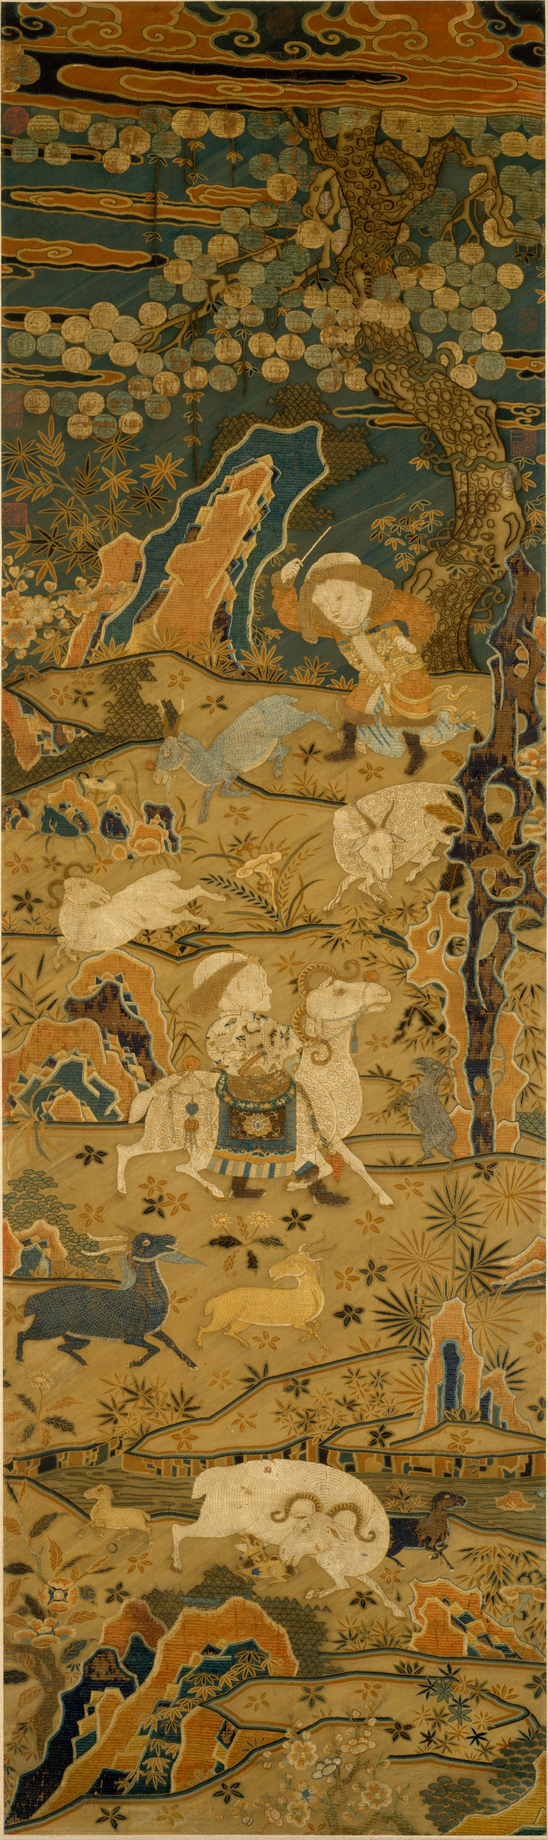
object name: panel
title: Welcoming spring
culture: chinese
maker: unidentified artist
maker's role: artist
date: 1401-1500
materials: textile, silk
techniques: embroidery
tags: boys,goats,sheep